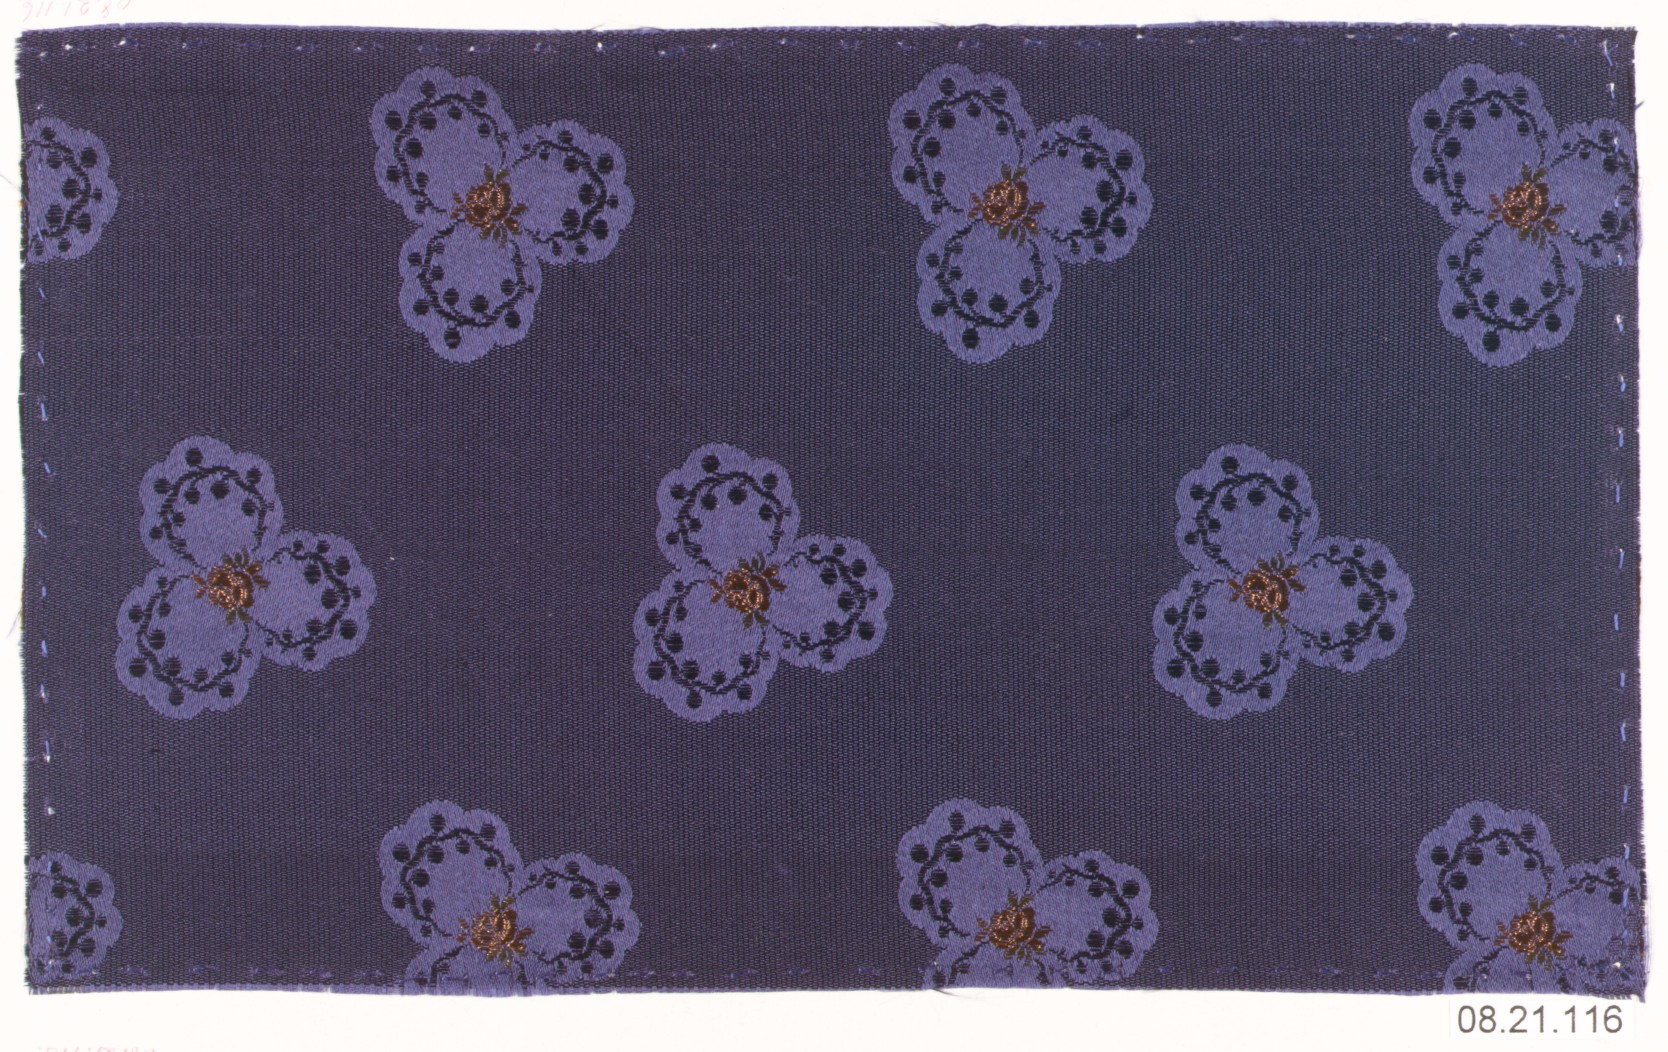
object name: textile sample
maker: Anonymous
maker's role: designer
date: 1900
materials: silk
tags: flowers